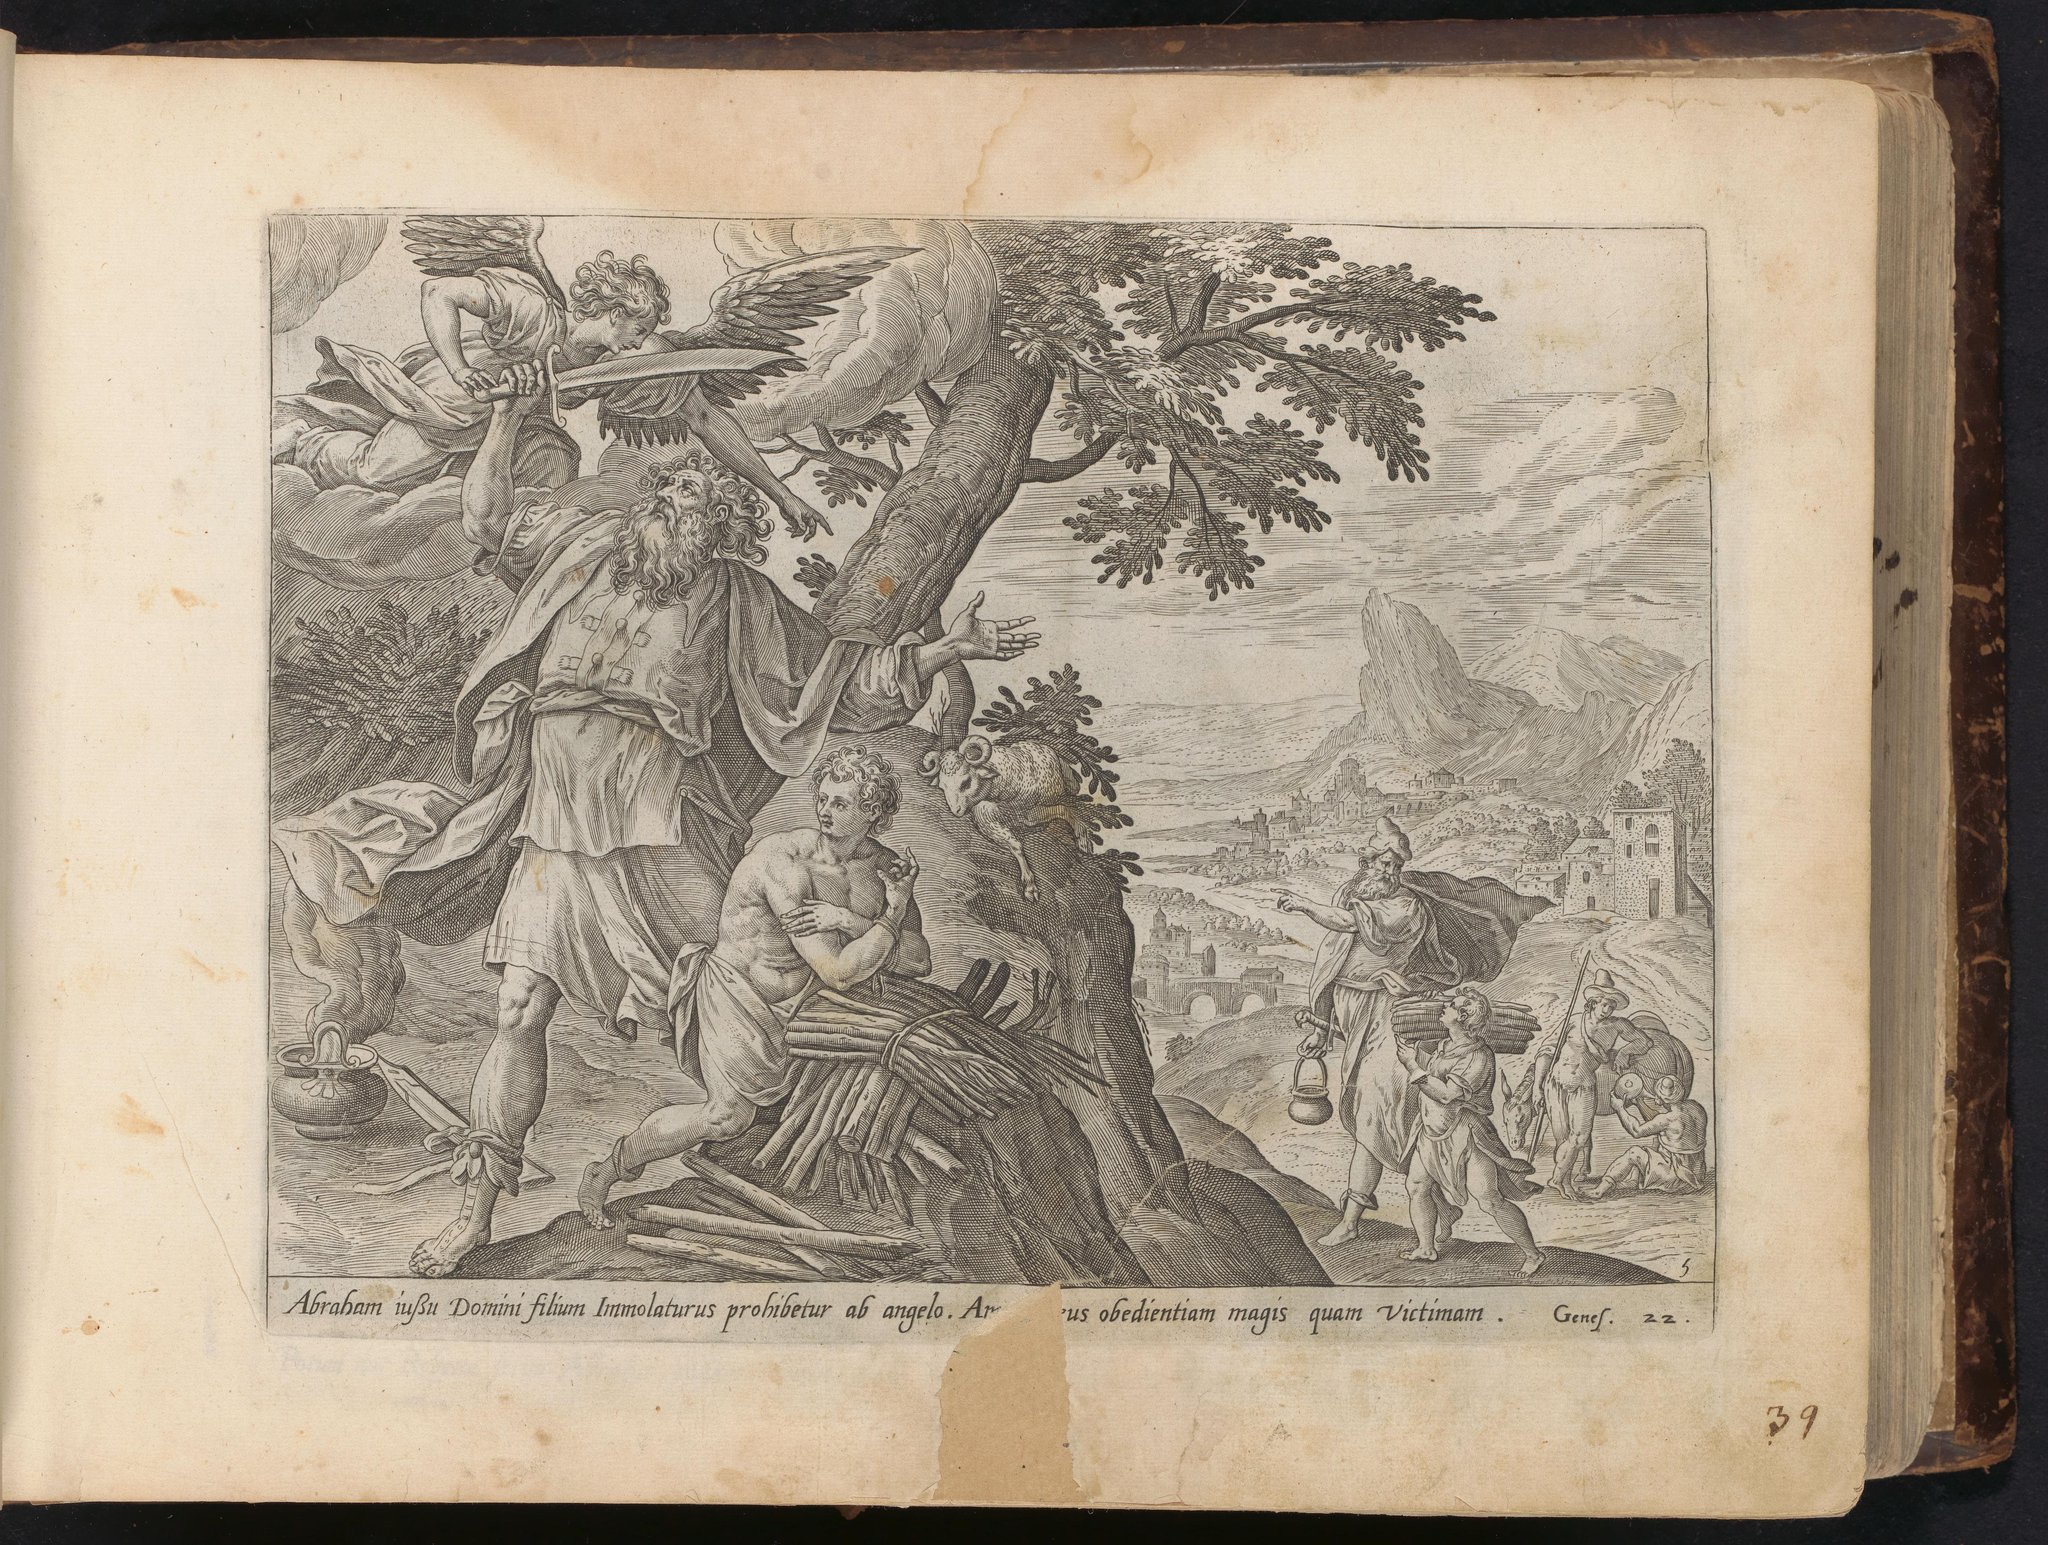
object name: print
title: Geschiedenis van Abraham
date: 1585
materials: paper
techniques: engraving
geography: amsterdam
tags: the servants are left behind while abraham and isaac (usually carrying wood) climb the mountain, when abraham has his hand raised to kill isaac, an angel restrains abraham's hand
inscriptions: number: ‘39’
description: Abraham heft zijn mes om zijn zoon Isaak te offeren, maar een engel weerhoudt hem daarvan. Rechts zit een ram in de struiken verstrikt, die in Isaaks plaats zal worden geofferd. Rechts in het landschap zijn Abraham en Isaak op weg naar de offerplaats, nadat ze de ezel en knechten hebben achtergelaten. Onder de voorstelling een verwijzing in het Latijn naar de Bijbeltekst in Gen. 22. Deze prent maakt deel uit van een album.